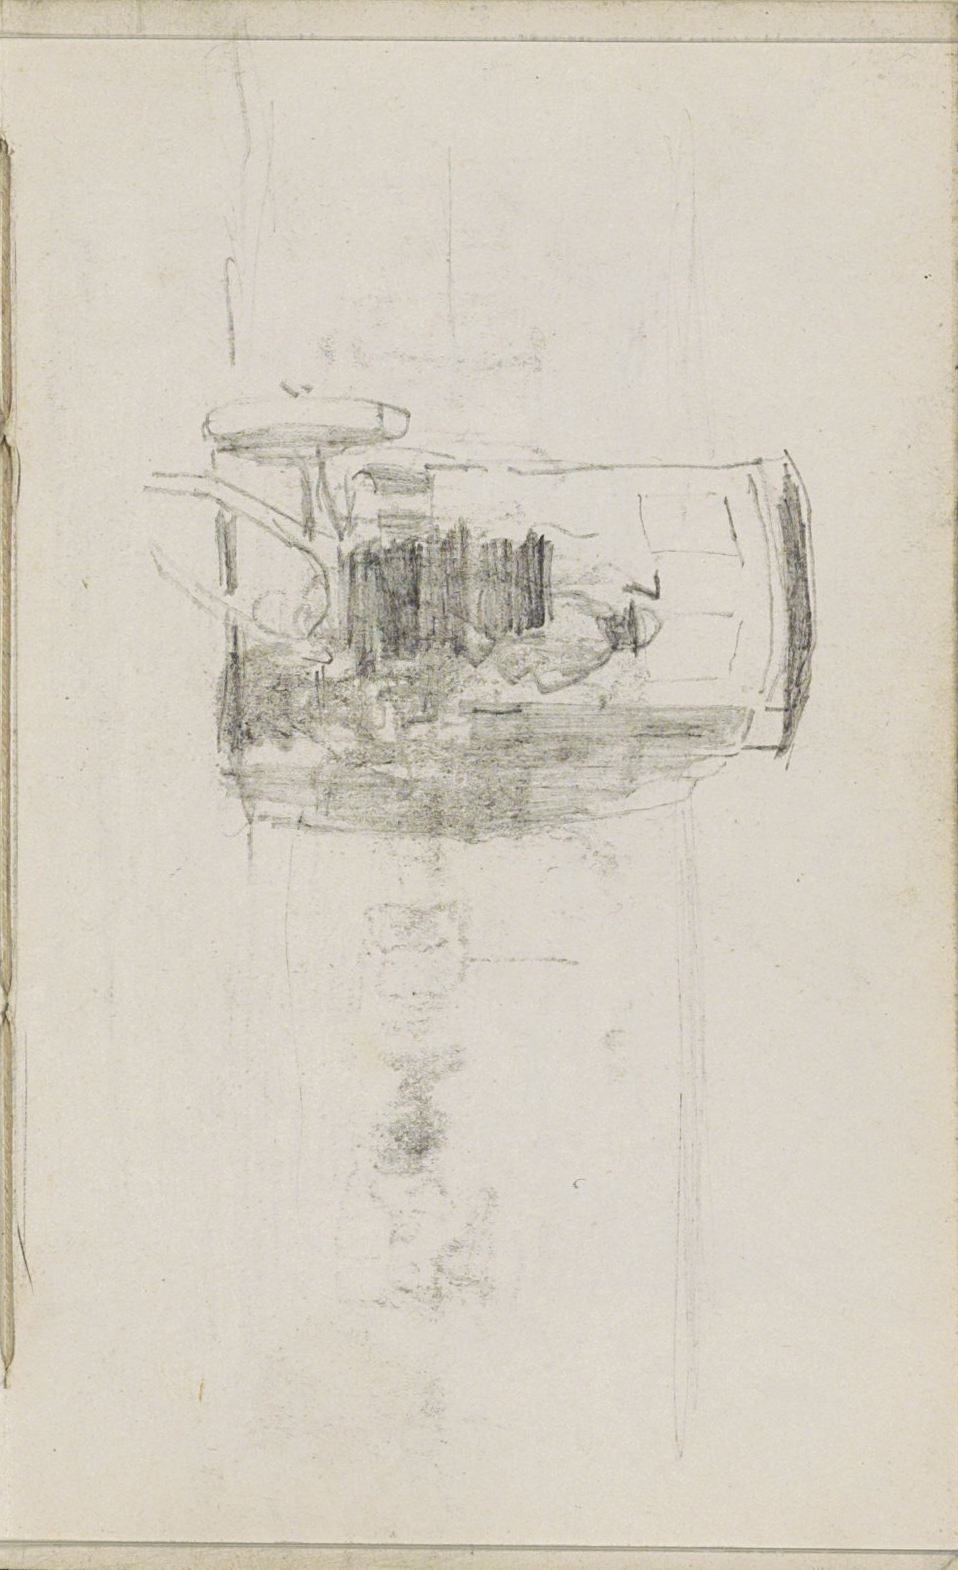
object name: sketchbook leaf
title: Figuur bij een badkoets op het strand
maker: anton mauve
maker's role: draughtsman, painter, print maker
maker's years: 1838-1888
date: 1848-1888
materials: chalk, paper, pencil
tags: beach (as place of recreation), animal traction, animal-drawn vehicle (carriage etc.)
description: Blad 45 recto uit een schetsboek met 53 bladen.